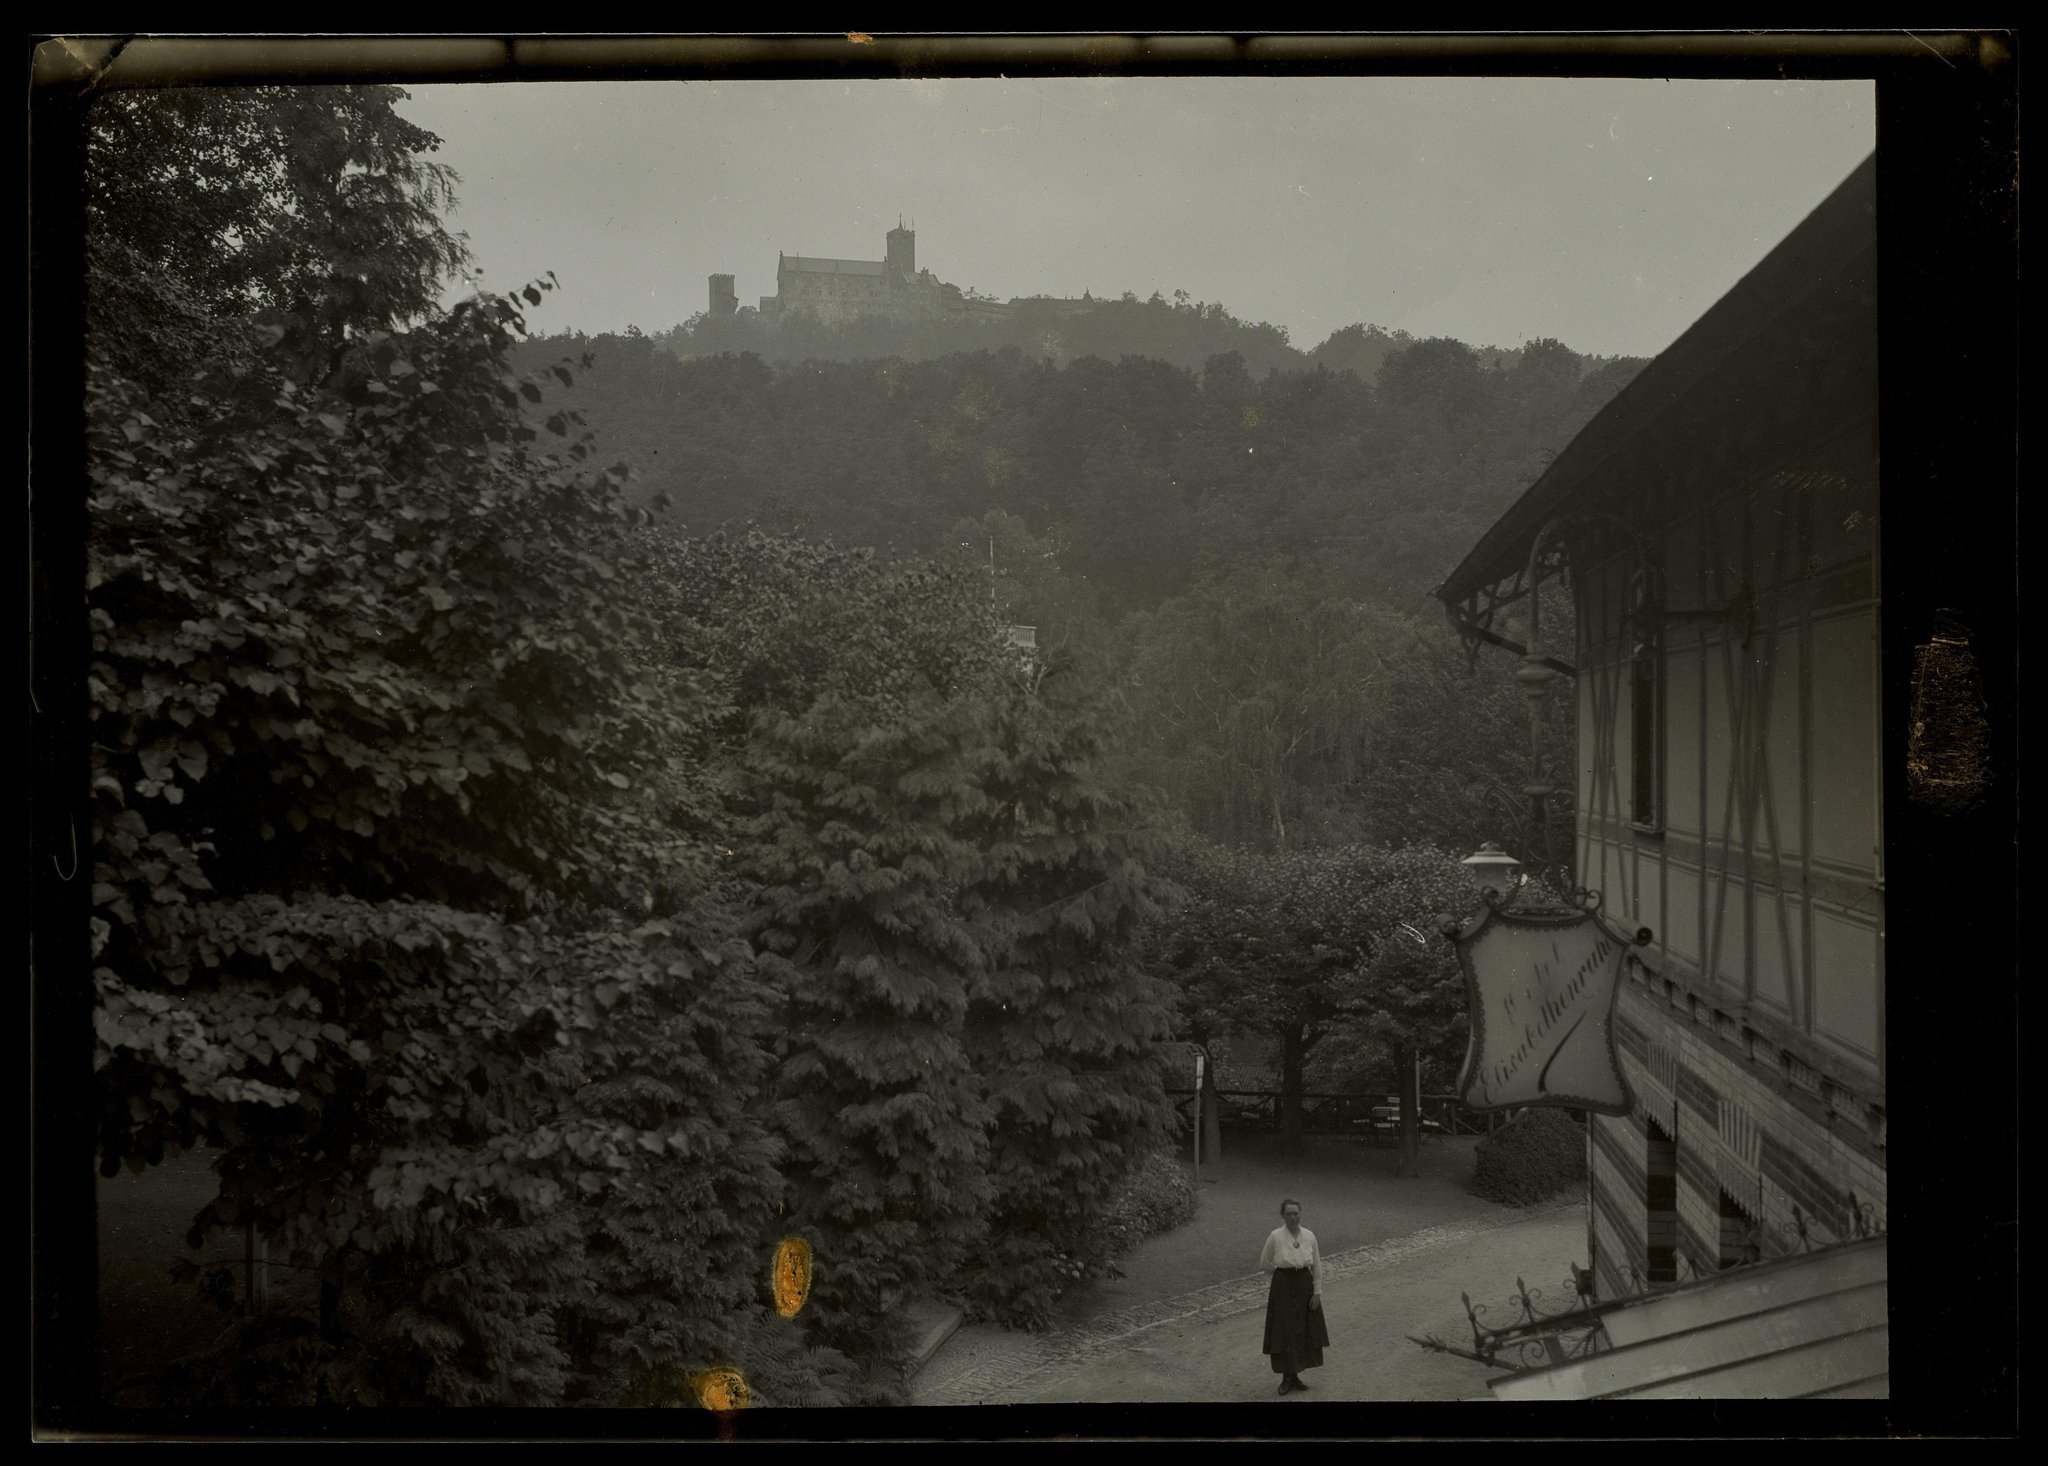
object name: photograph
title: Filmnegatief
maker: Anonymous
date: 1907-1935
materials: film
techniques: gelatin silver negative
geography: europe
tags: europe